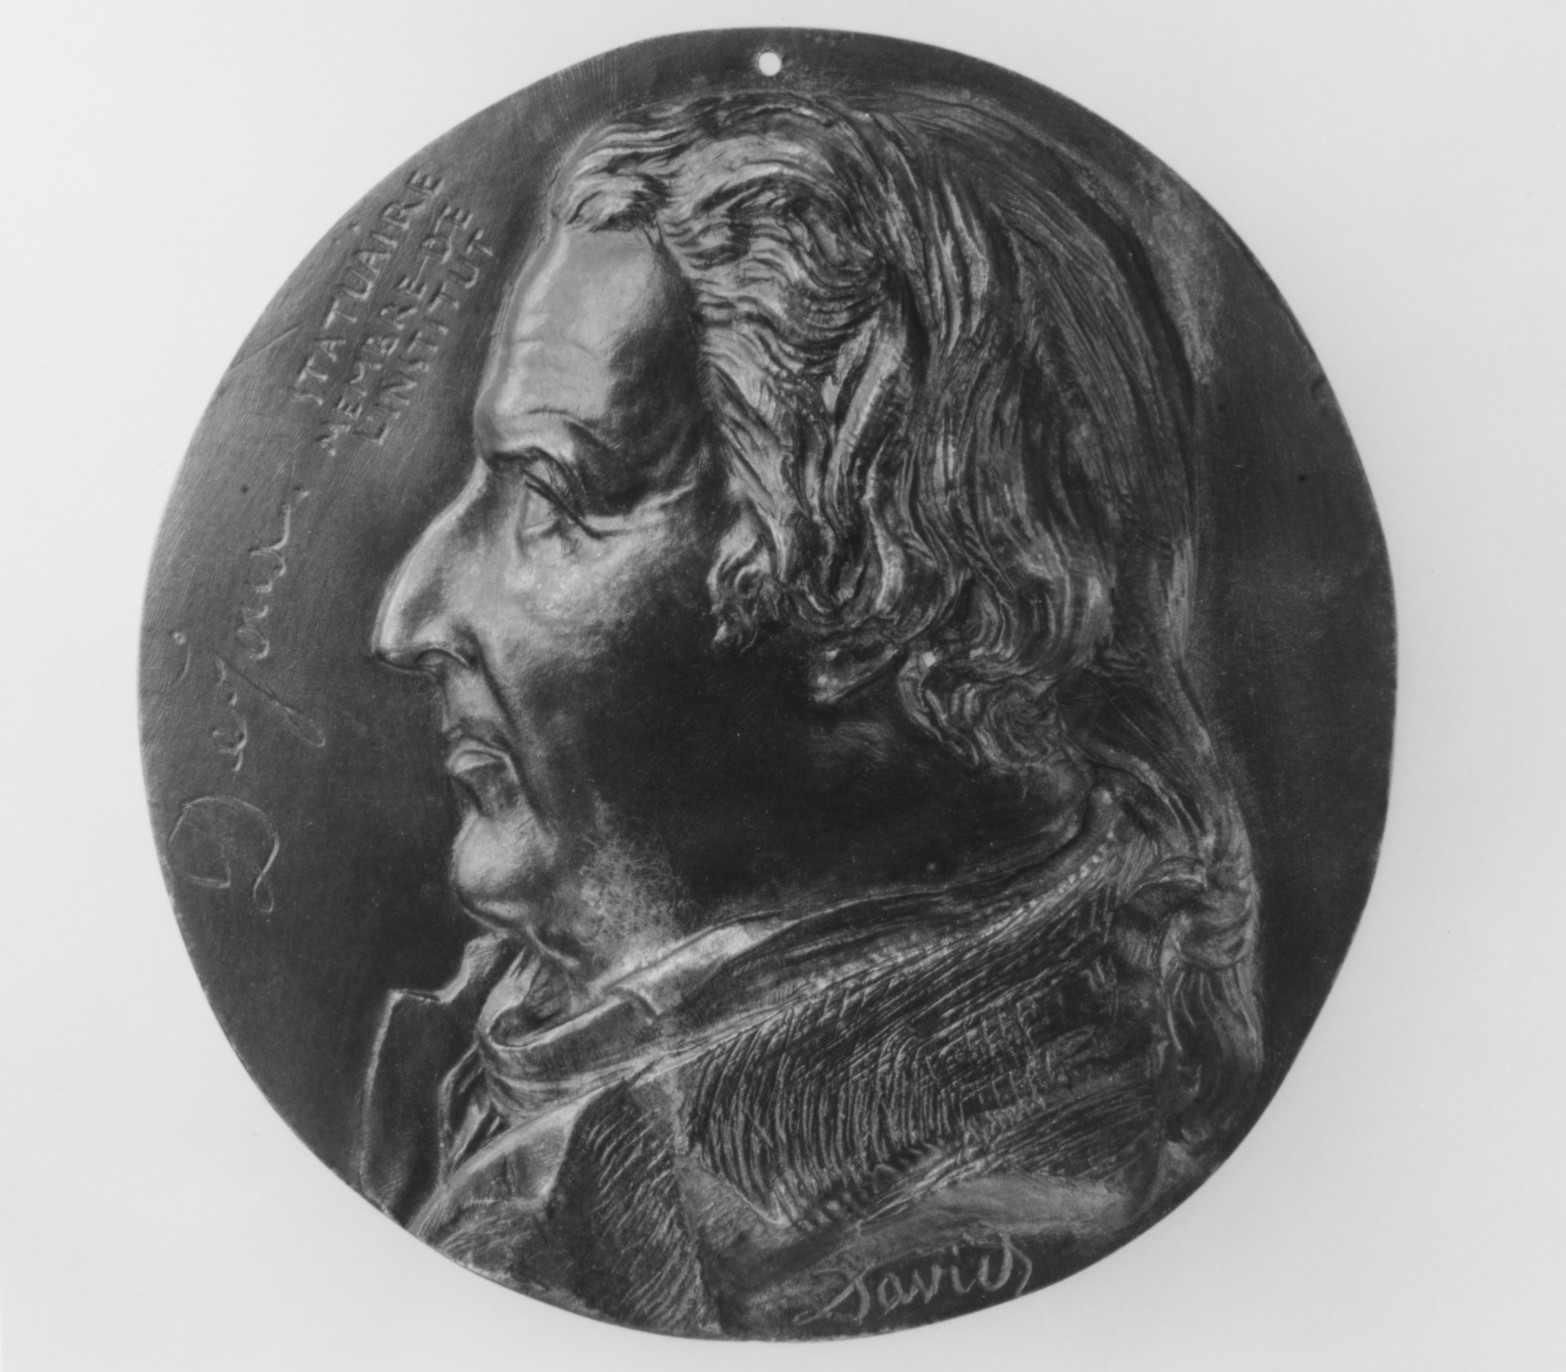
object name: medallion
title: Portrait of Claude Dejoux (1732–1816)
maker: pierre jean david d'angers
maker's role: artist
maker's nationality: french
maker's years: 1788-1856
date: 1834-1866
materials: bronze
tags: men,profiles